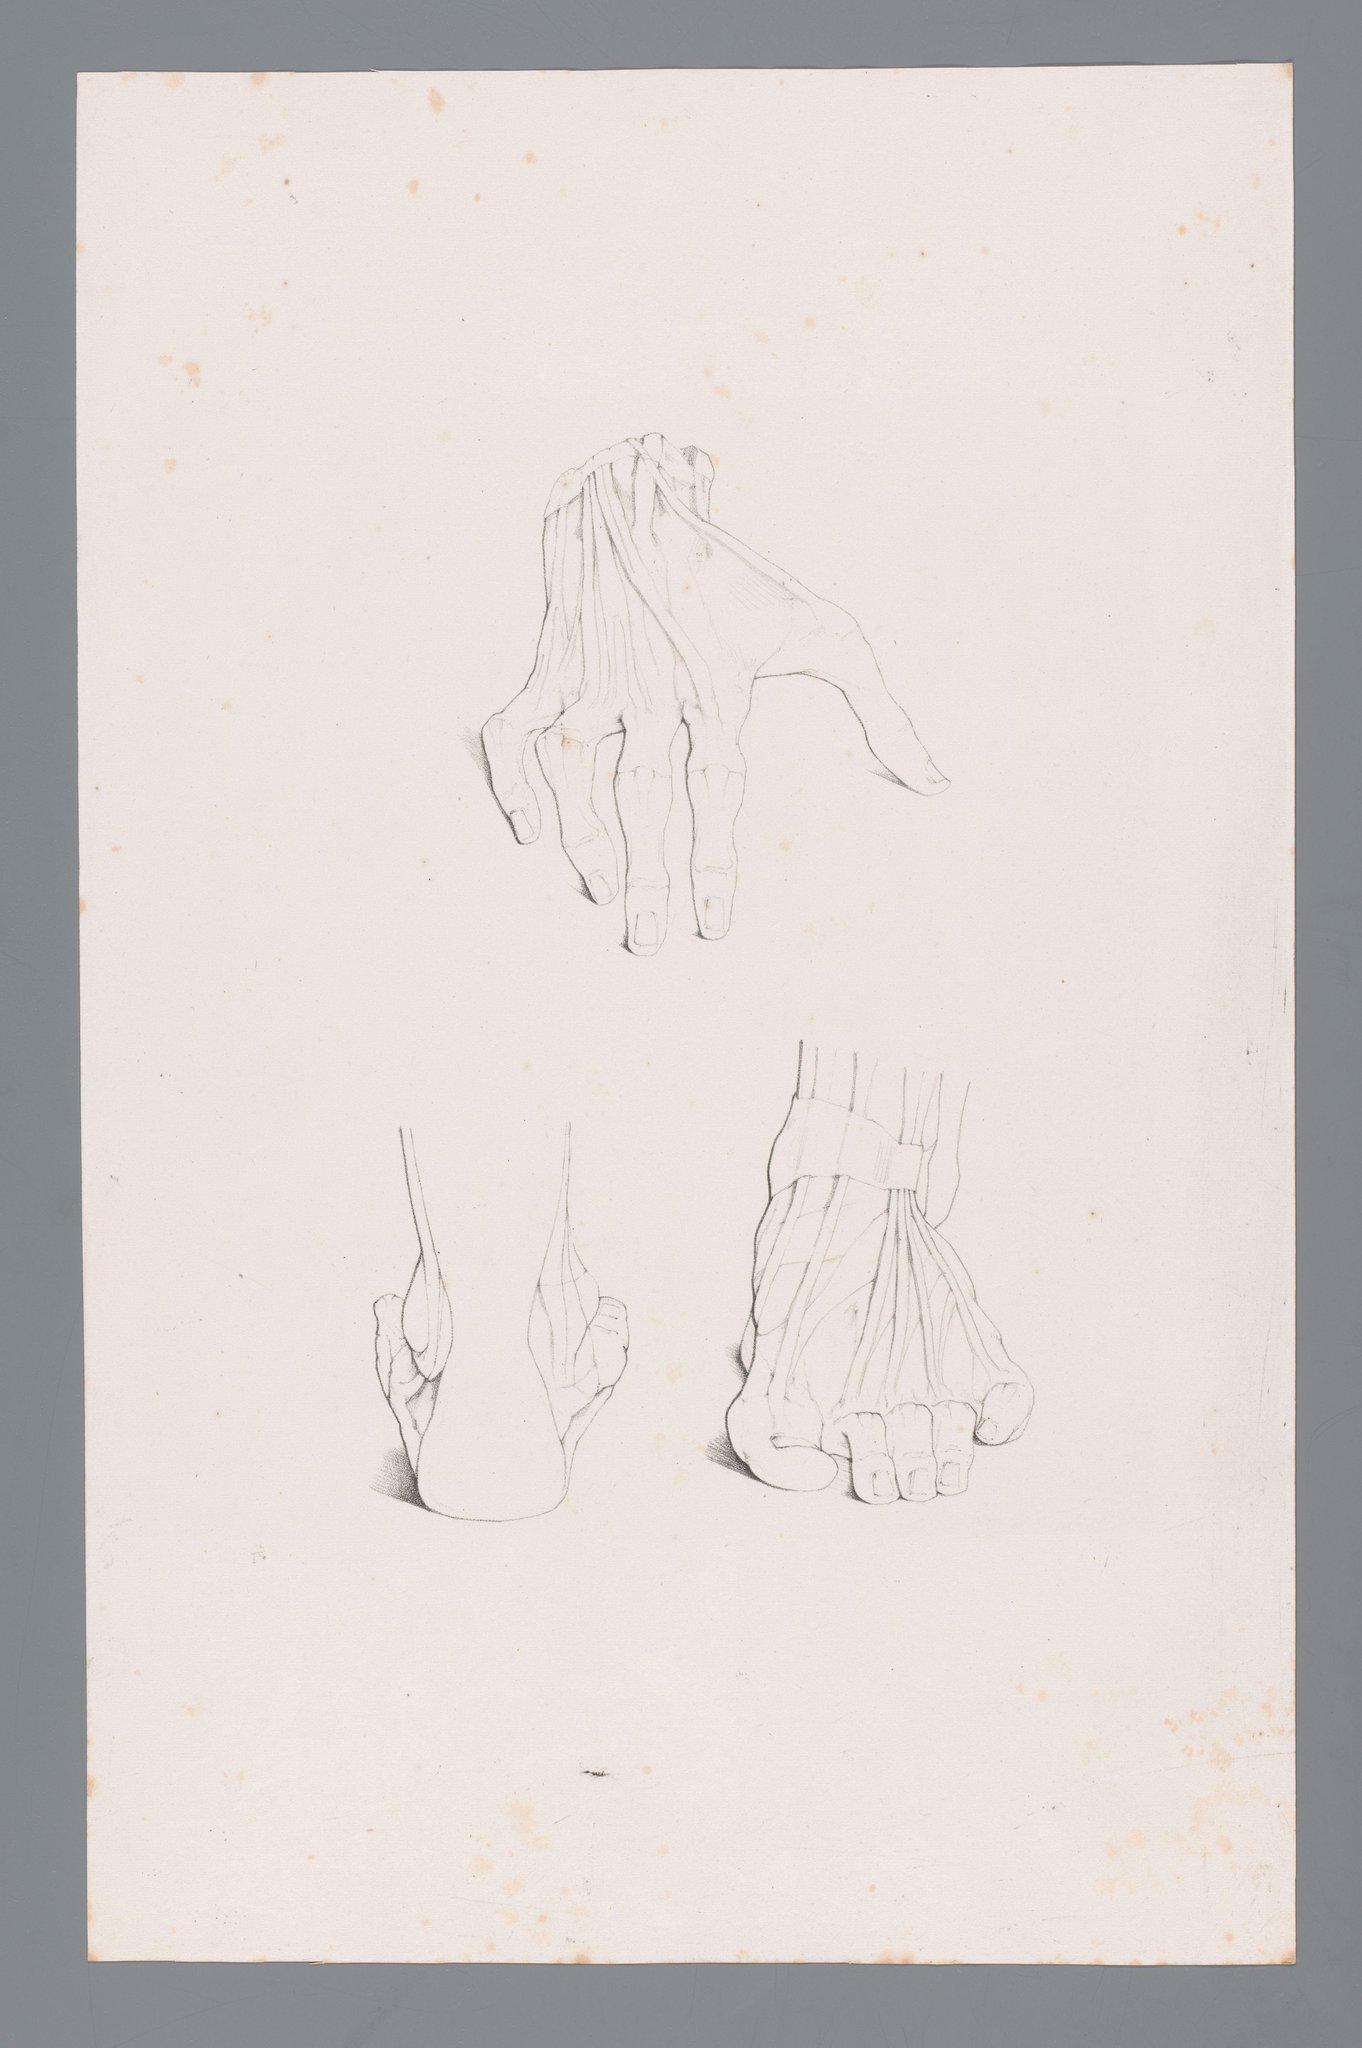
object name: print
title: Anatomie-studien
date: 1828-1830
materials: paper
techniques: lithograph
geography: amsterdam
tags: hand, foot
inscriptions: watermark, collector's mark: Lugt 2228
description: Onderdeel van een omslag met in totaal achttien anatomische voorstellingen.